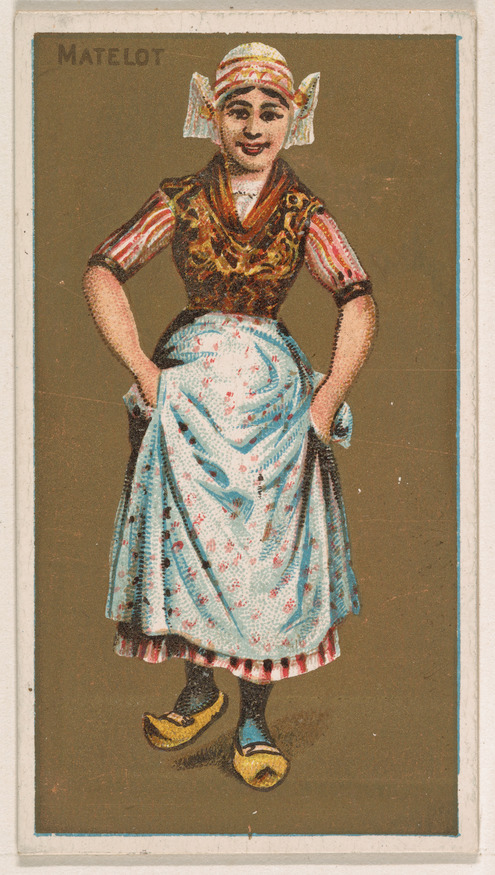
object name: print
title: Matelot, from National Dances (N225, Type 1) issued by Kinney Bros.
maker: kinney brothers tobacco company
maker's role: publisher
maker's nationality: american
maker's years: 1869-2011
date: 1889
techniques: color lithograph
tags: women,dancing,dancers